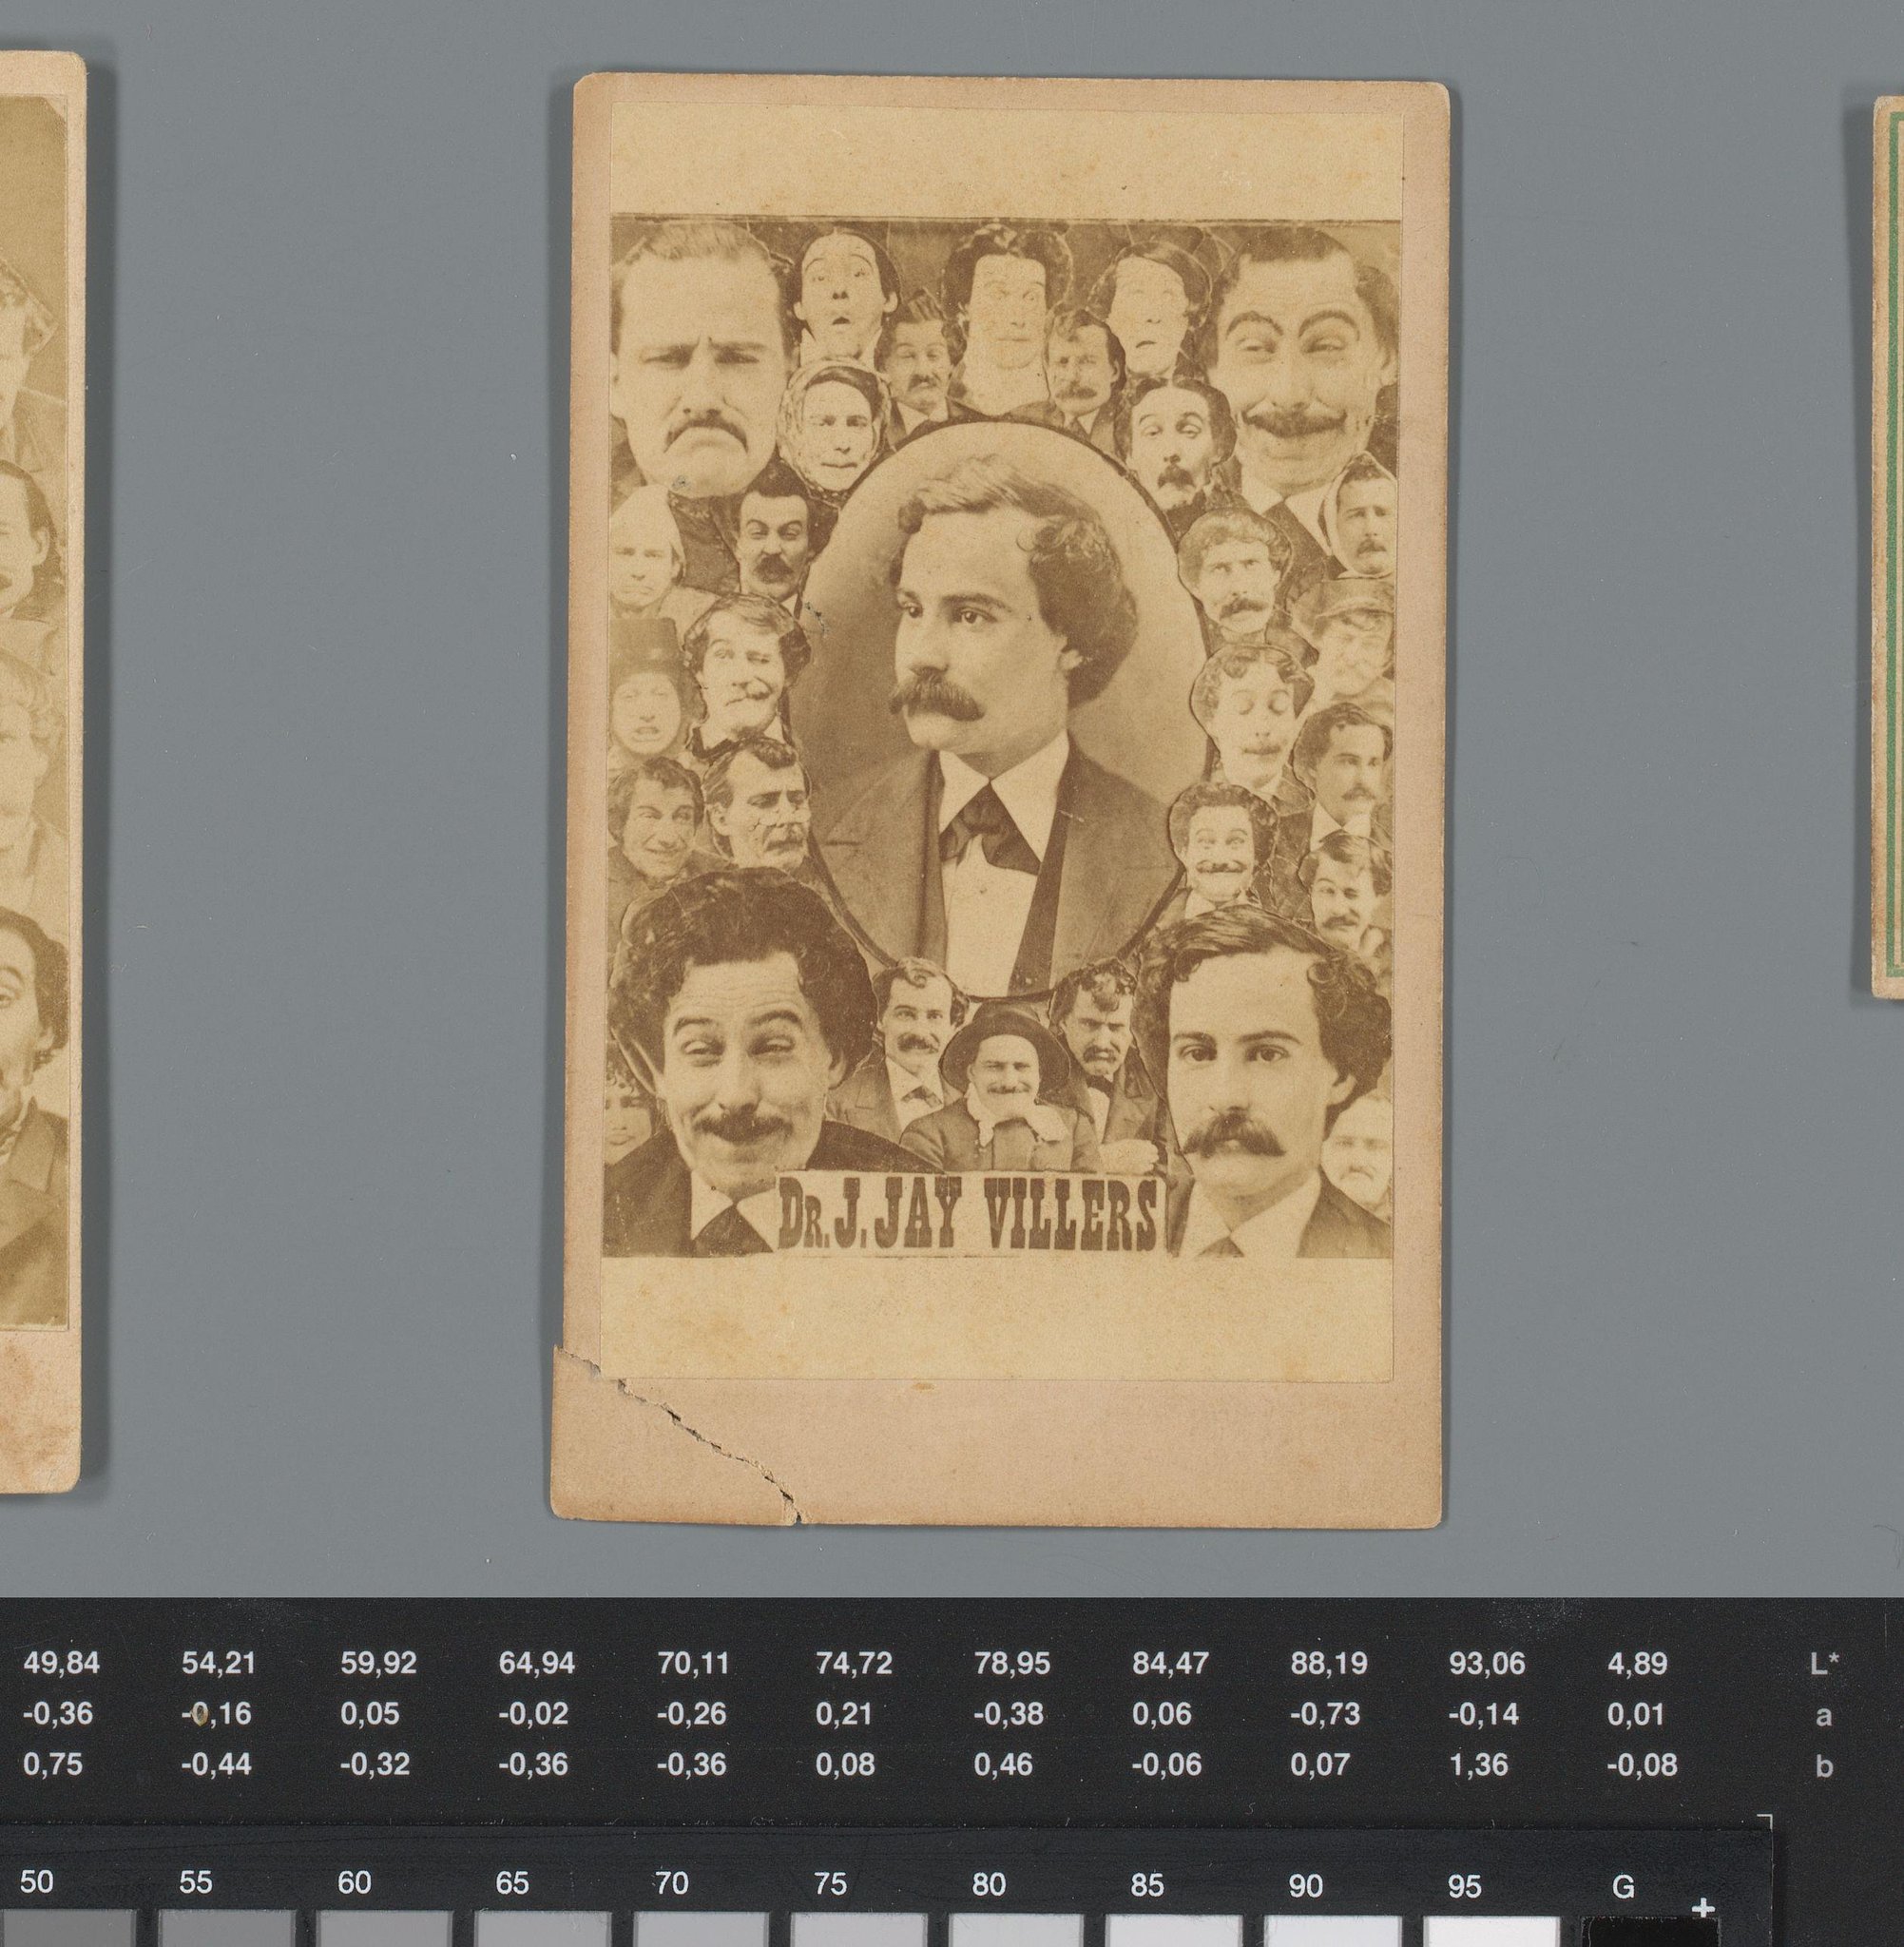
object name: photograph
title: Reclame voor voorstellingen van komiek Joseph Jay Villers met een collage van zijn portretten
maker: Anonymous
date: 1850-1915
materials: cardboard, photographic support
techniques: albumen print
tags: performance, advertising, historical persons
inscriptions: inscription: ‘Dr. J. JAY VILLERS / (GRUMPTOWN PIDOGAH CUTE,) / In three entirely new Humorous Entertainments entitled: FUNNY PEOPLE WE MEET (...)’